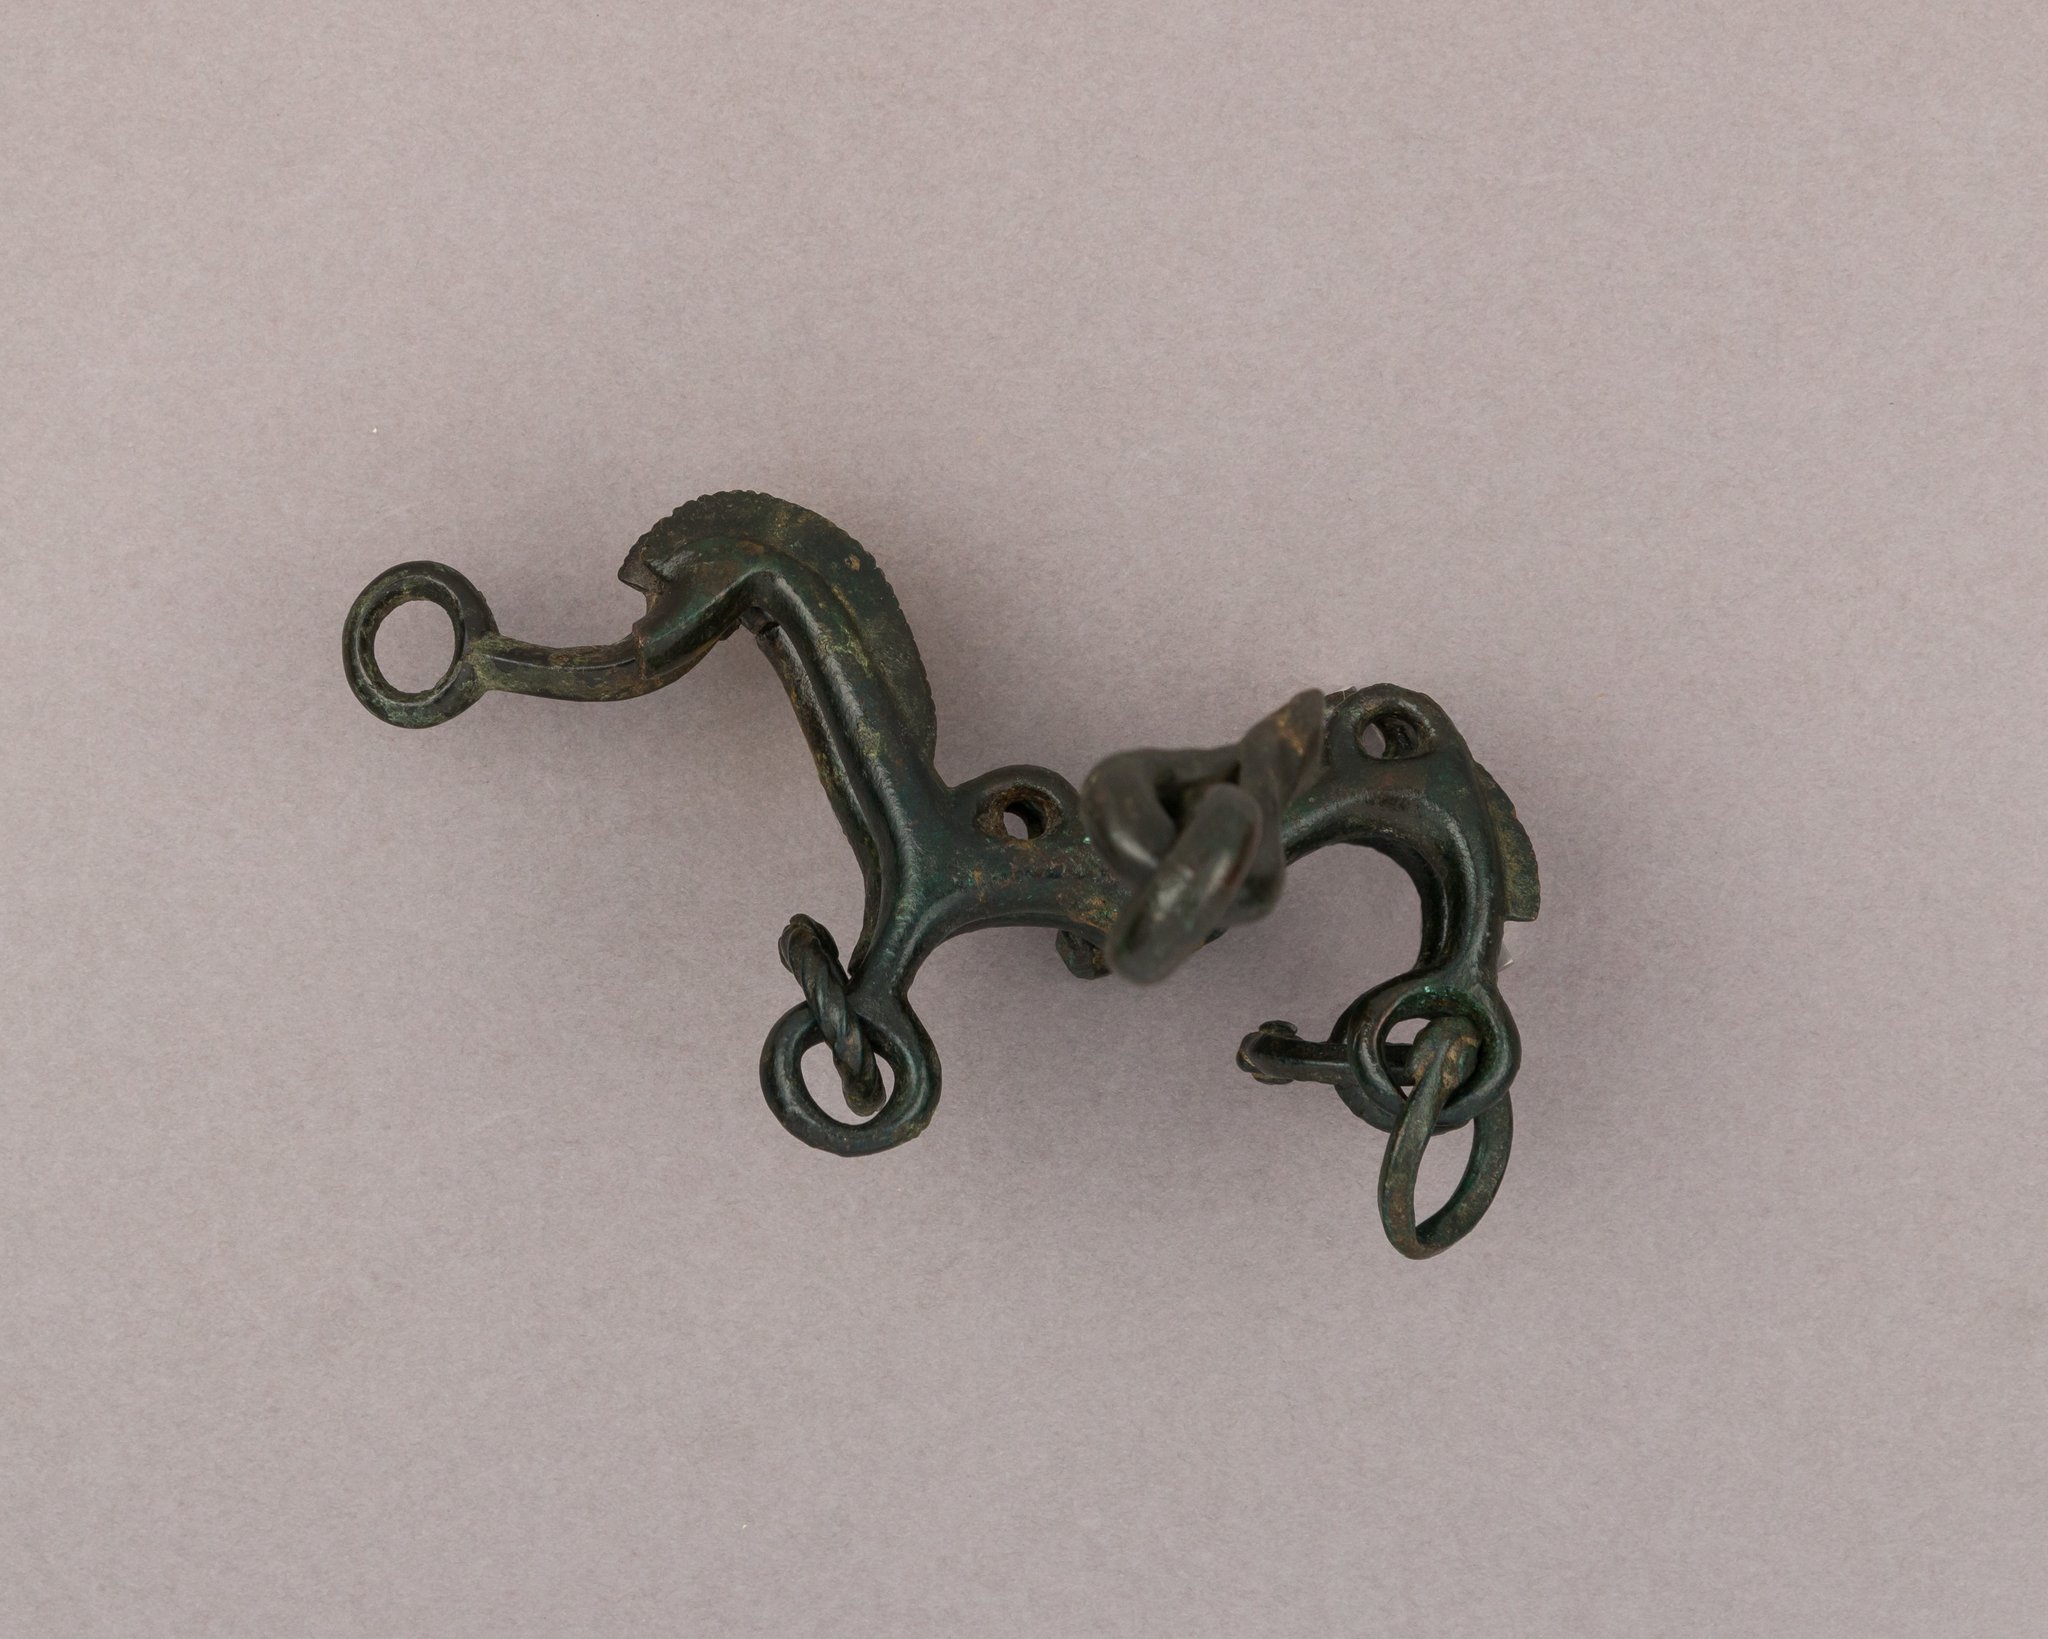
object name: bit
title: Snaffle Bit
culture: villanovan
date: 800-601 BCE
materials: copper alloy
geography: italy